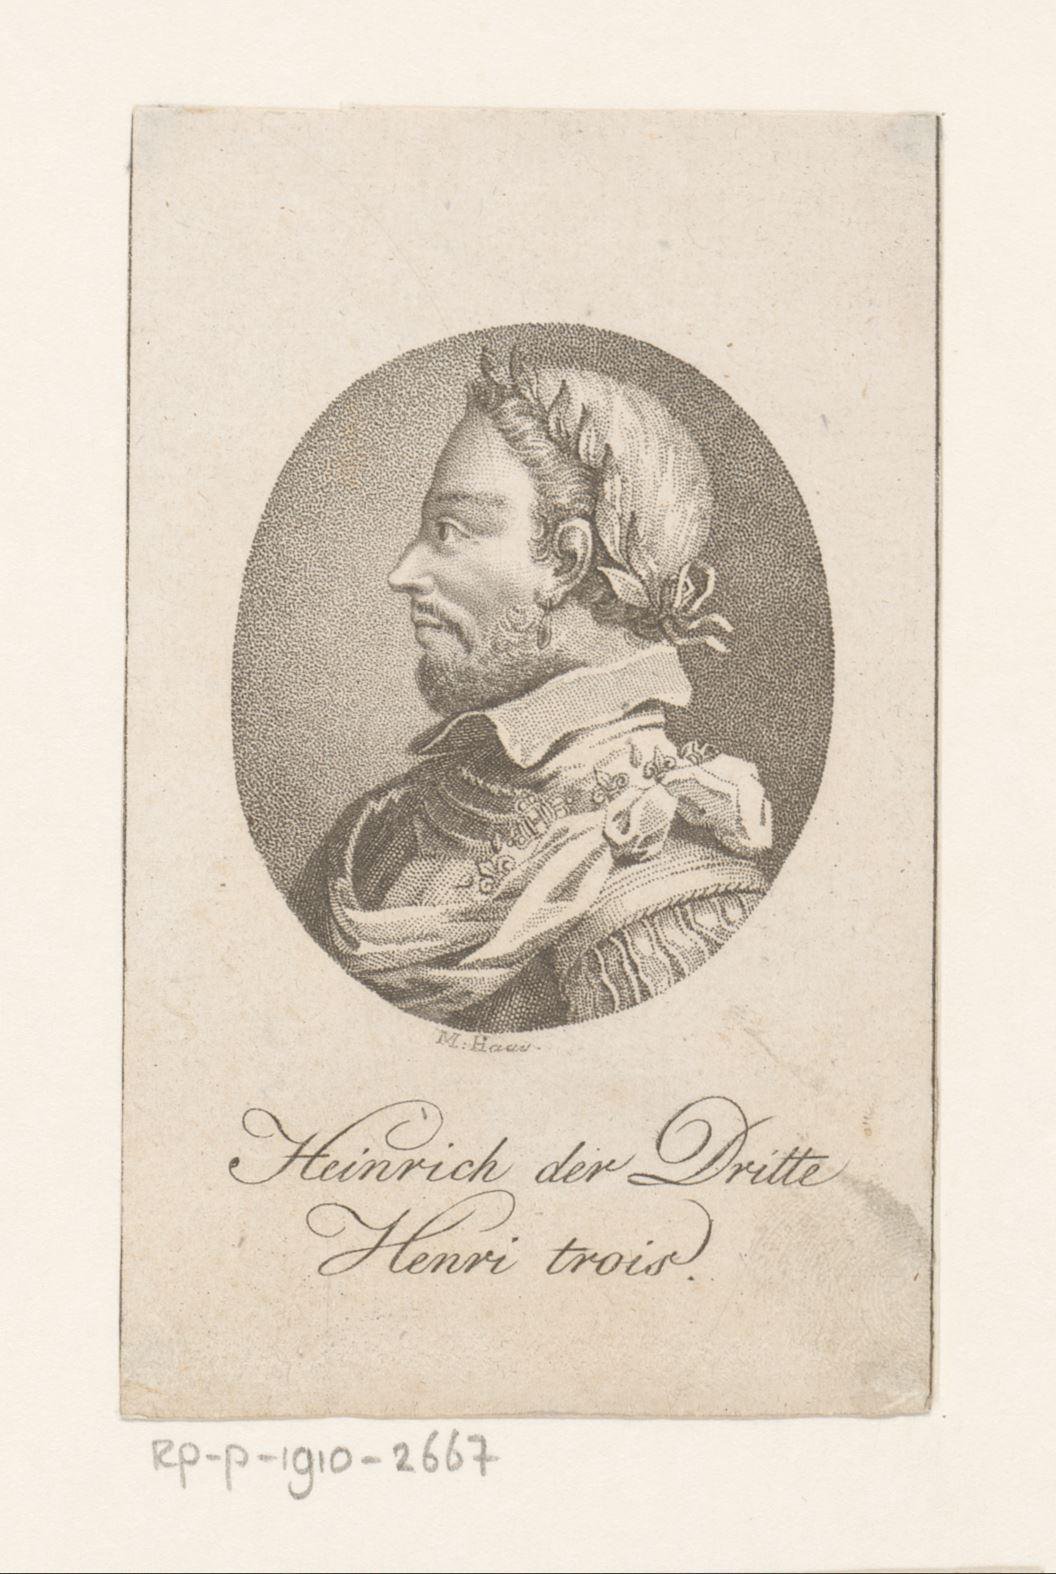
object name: print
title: Portret van Hendrik III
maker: meno haas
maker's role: print maker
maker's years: 1752-1833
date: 1762-1833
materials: paper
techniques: stippling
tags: historical persons, crowning with laurel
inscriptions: collector's mark: Lugt 2228